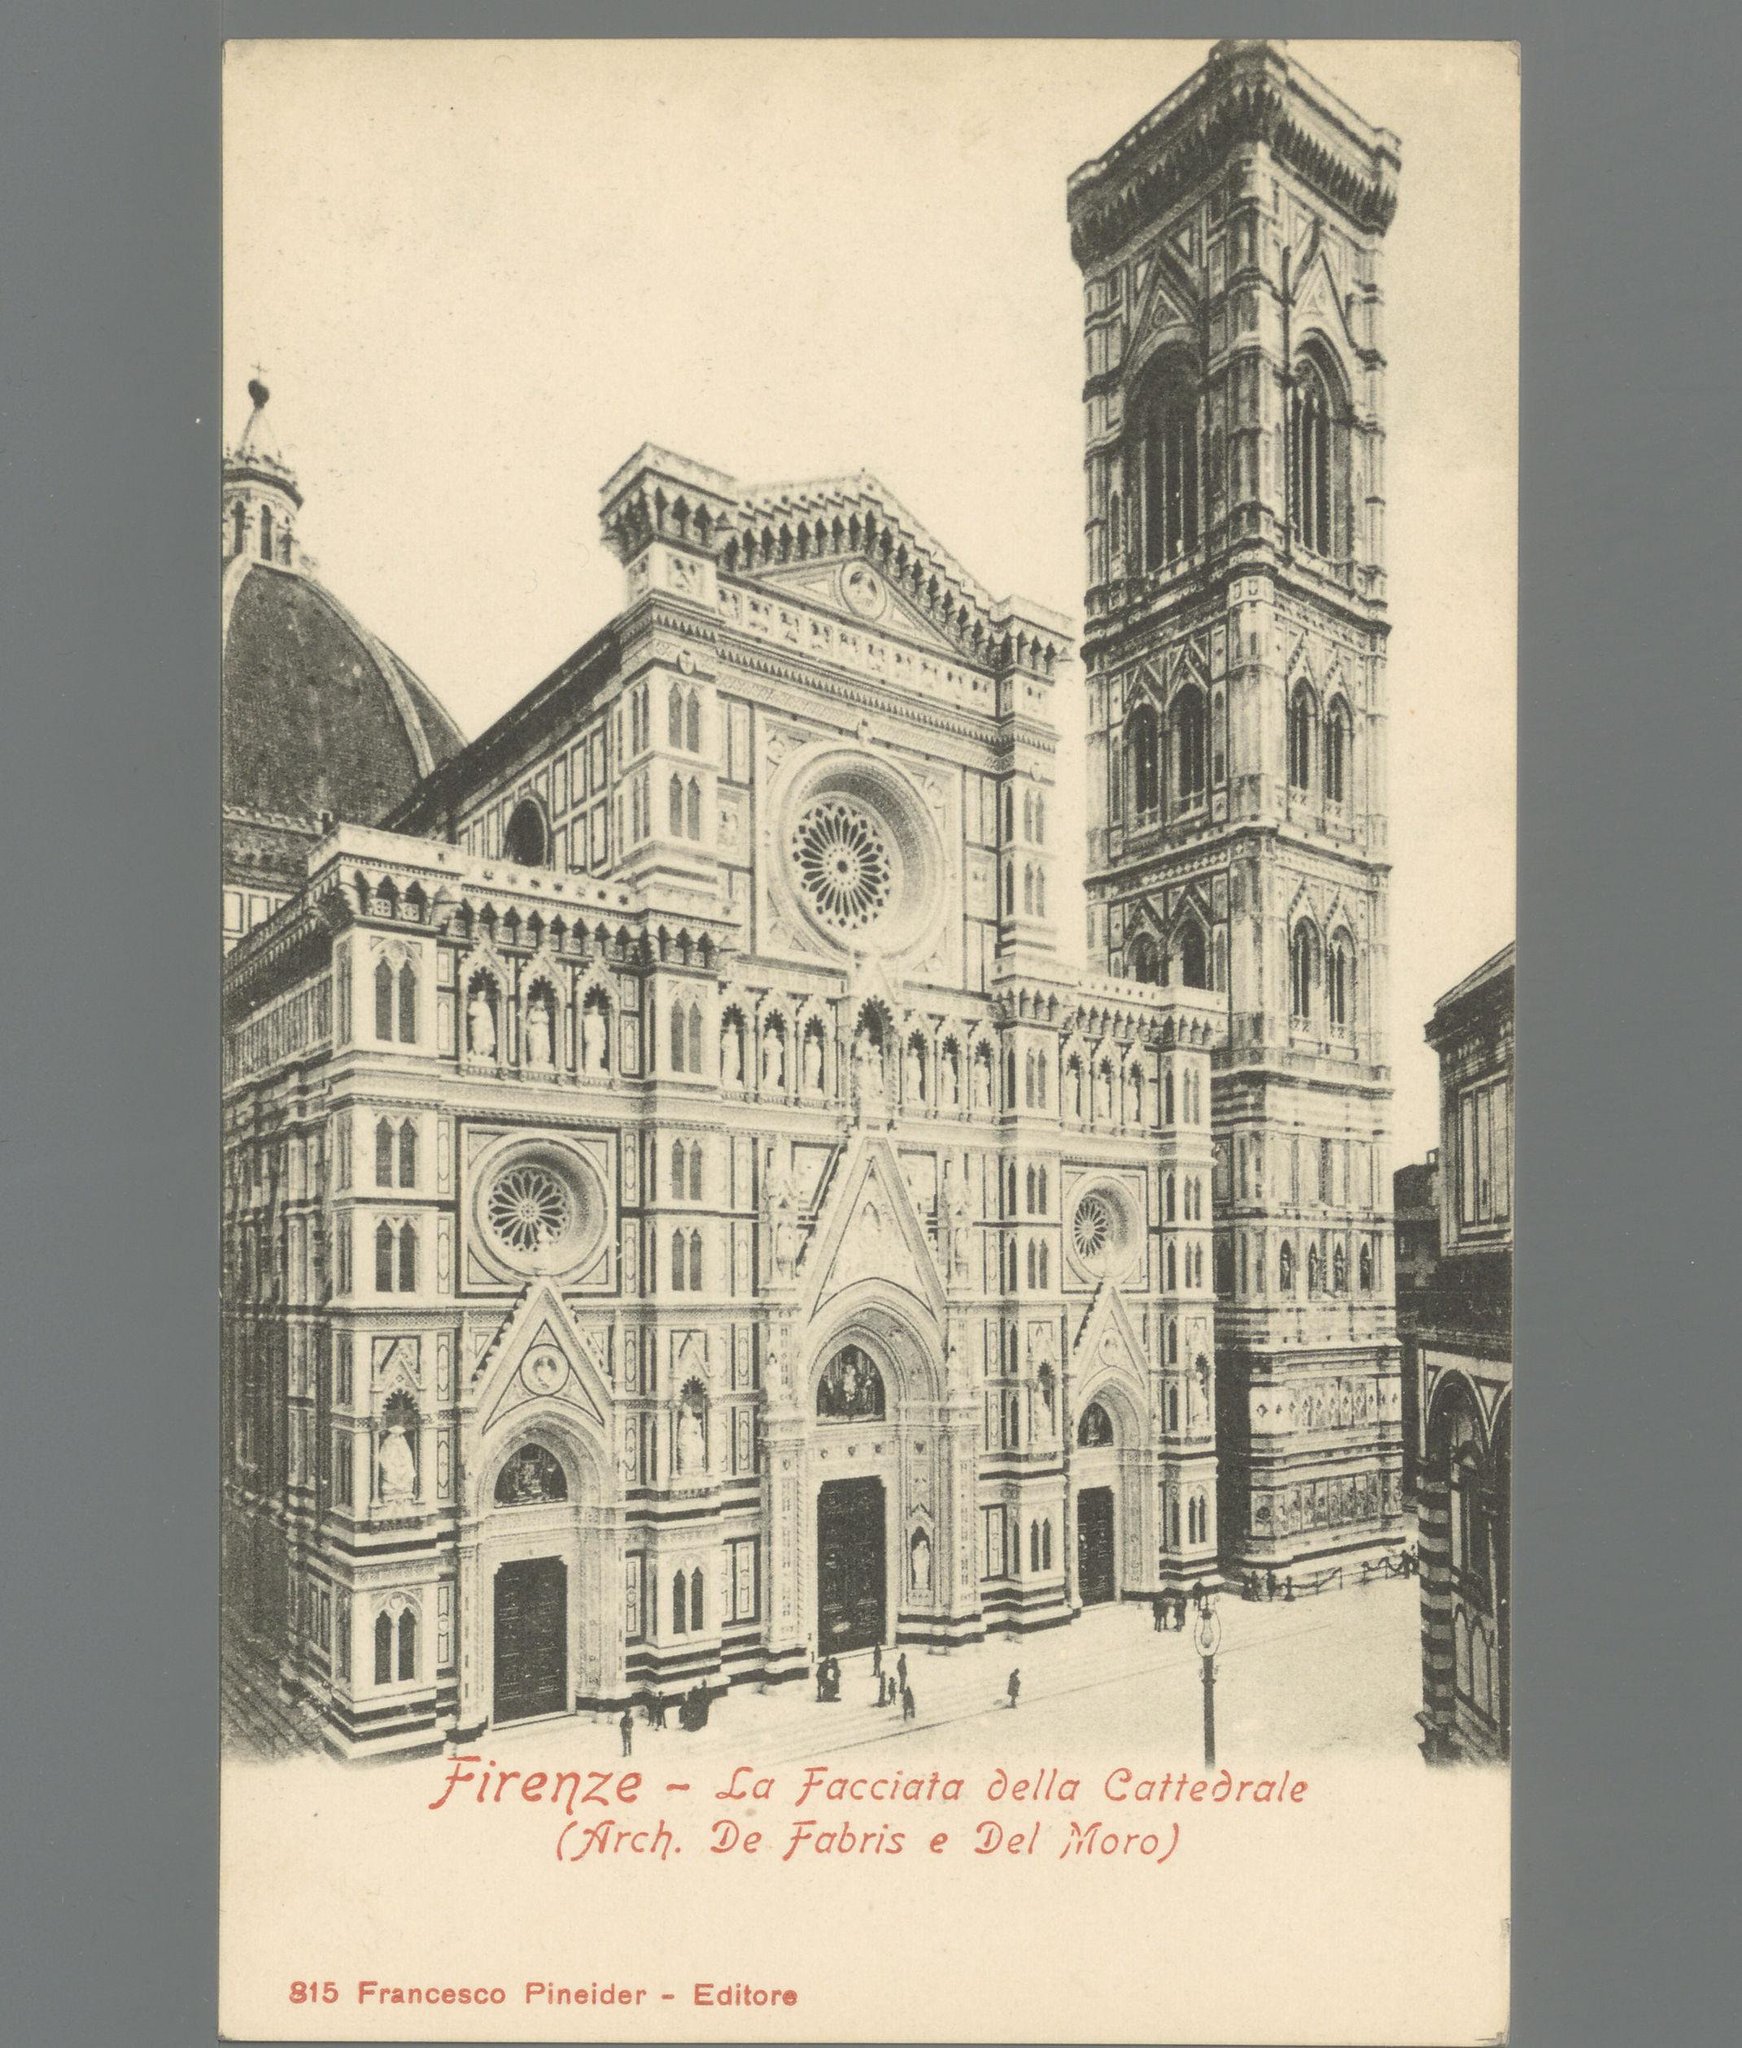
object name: photomechanical print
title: Firenze. La Facciata della Cattedrale (Arch. De Fabris e Del Moro)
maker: Anonymous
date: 1889-1906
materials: cardboard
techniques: photograph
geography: florence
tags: church (exterior), city-view, and landscape with man-made constructions (+ city(-scape) with figures, staffage)